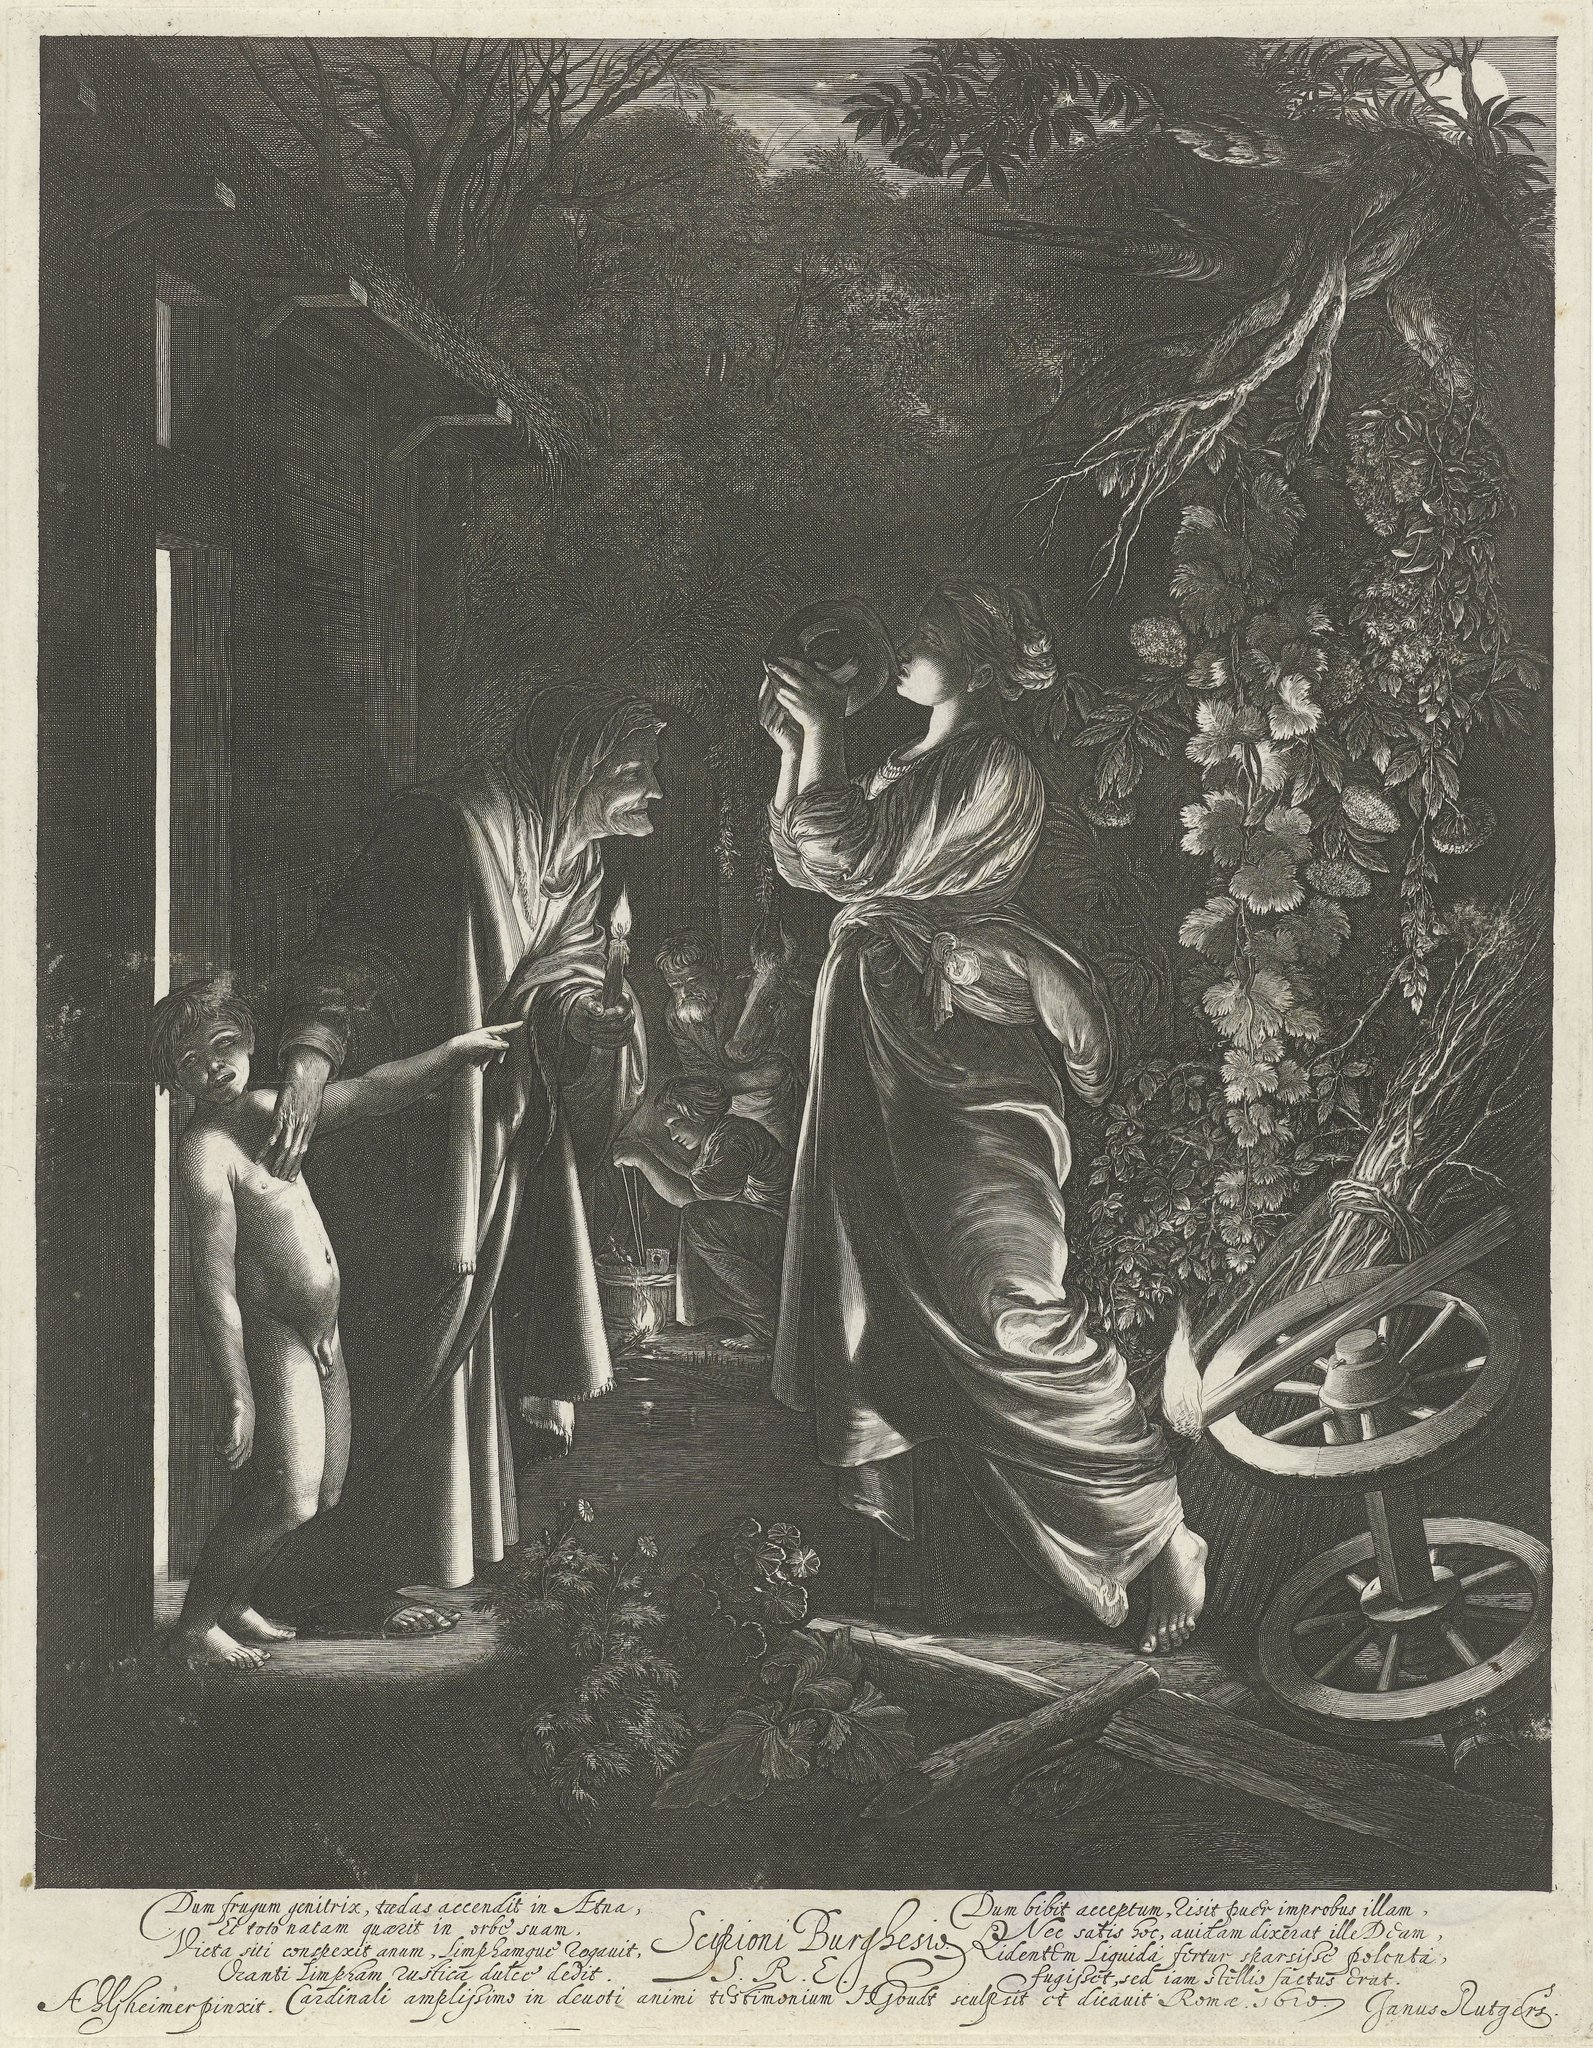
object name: print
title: Bespotting van Ceres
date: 1610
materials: paper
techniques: engraving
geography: rome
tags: a little boy (abas, ascalabus, or stellio) laughs at ceres, because she drinks too avidly while she is resting at an old woman's house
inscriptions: collector's mark: Lugt 10, collector's mark: Lugt 11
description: De godin Ceres, op zoek naar haar dochter Proserpina, rust uit bij een hut. Ze drinkt uit een kruik, gegeven aan haar door een oude vrouw. Een kleine naakte jongen naast de oude vrouw wijst naar Ceres en lacht haar uit. De prent heeft een Latijns onderschrift. Naar een schilderij van Adam Elsheimer.